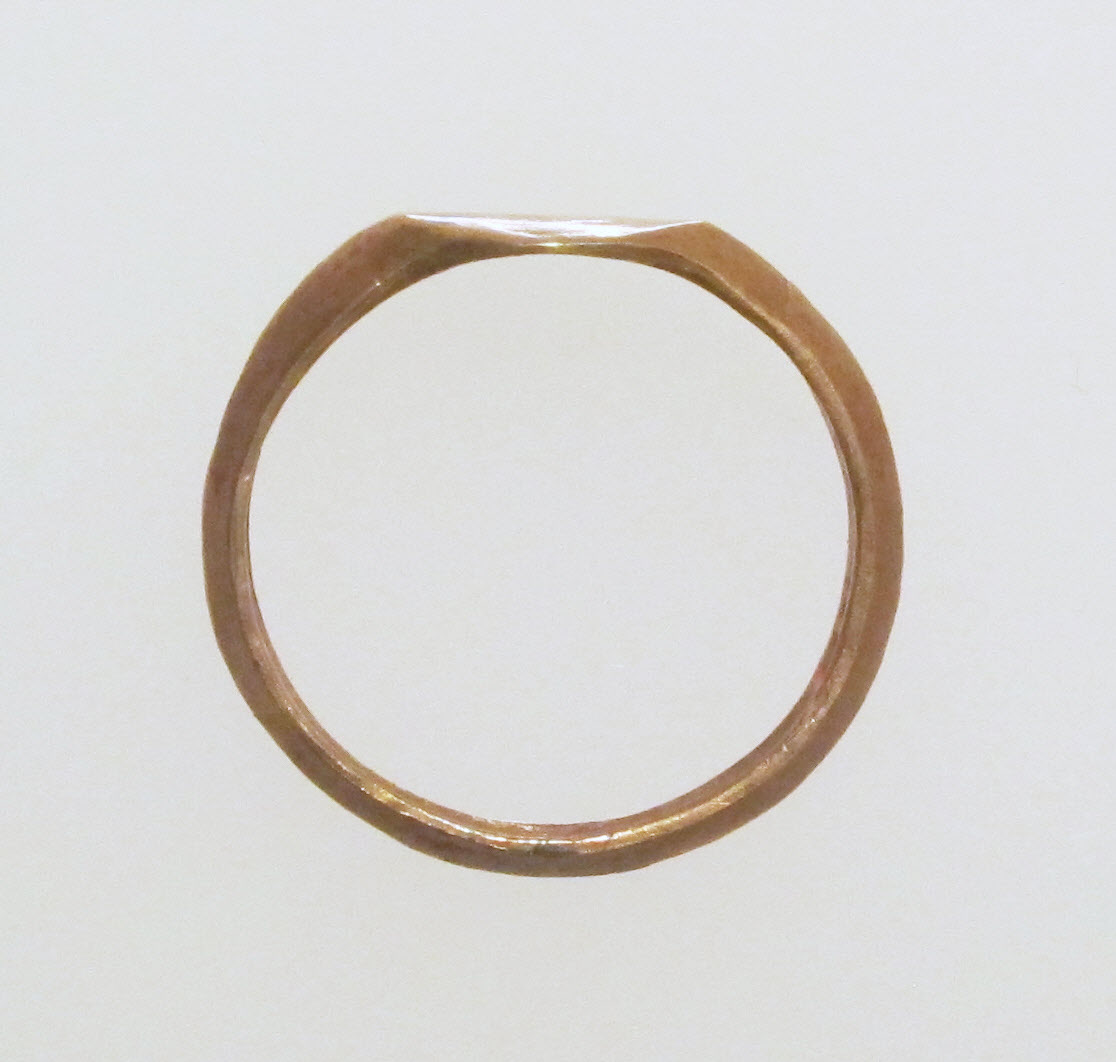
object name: ring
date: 7000 BCE-330 CE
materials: gold